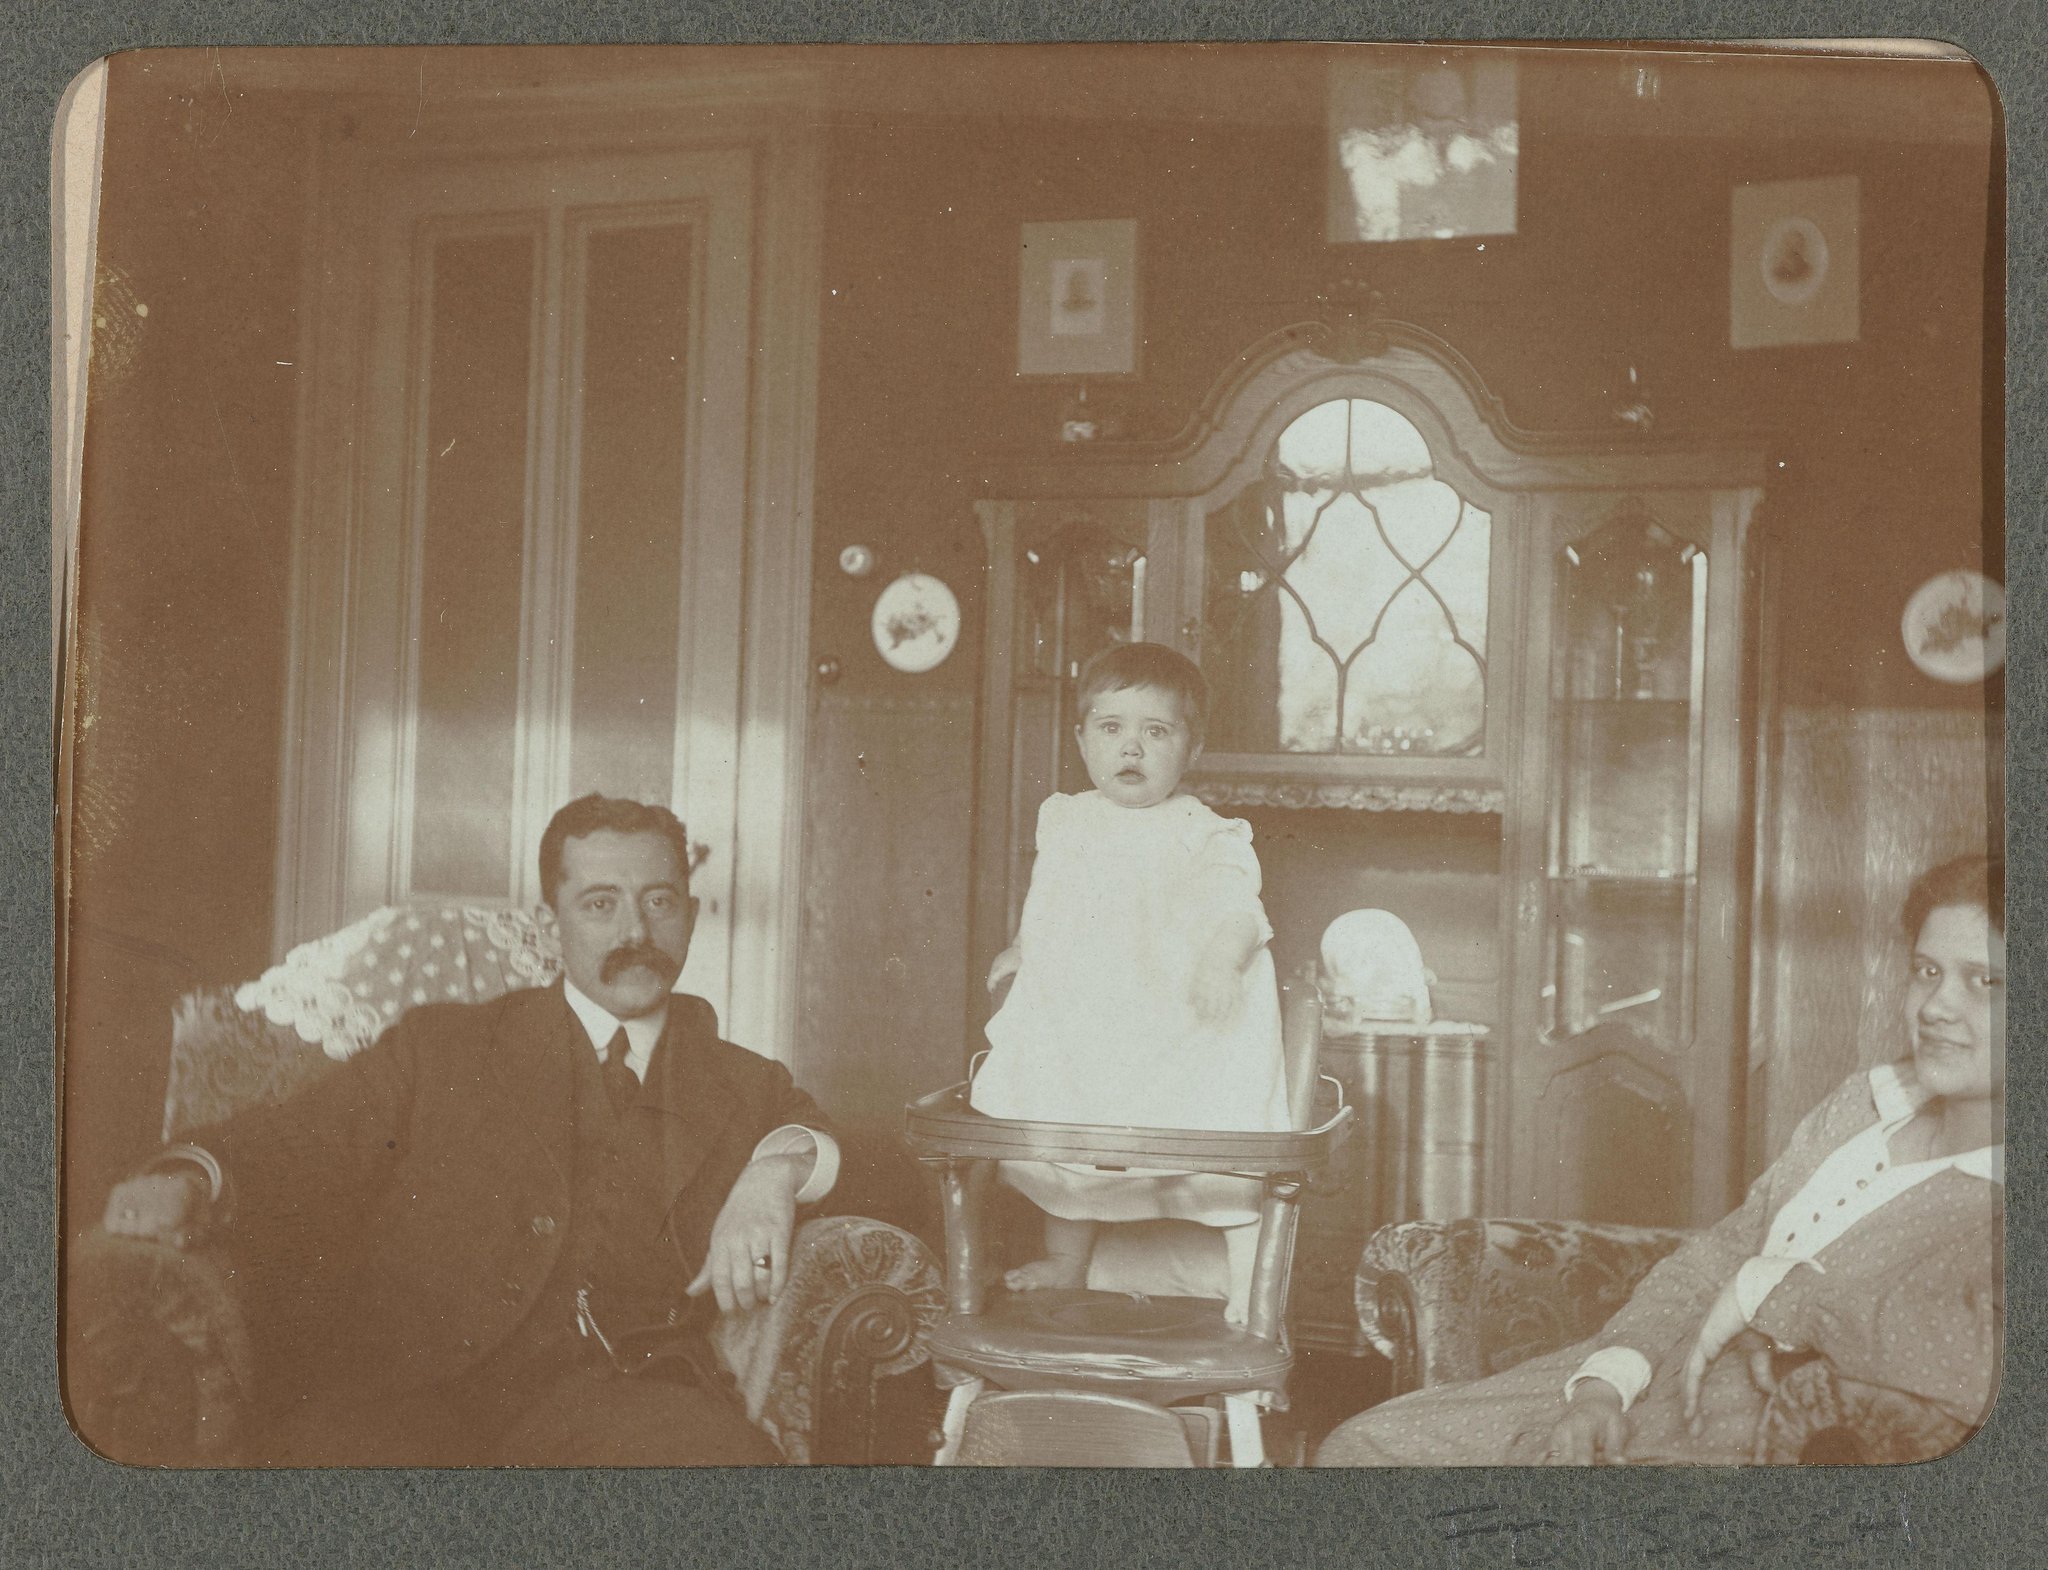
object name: album leaf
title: Portret van een man, een vrouw en een kind in een interieur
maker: christiaan otto roelofs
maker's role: fotograaf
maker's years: 1882-1970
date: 1900-1915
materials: photographic support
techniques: gelatin silver print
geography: netherlands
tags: family group, especially parents with their child(ren), historical persons, interior of the house